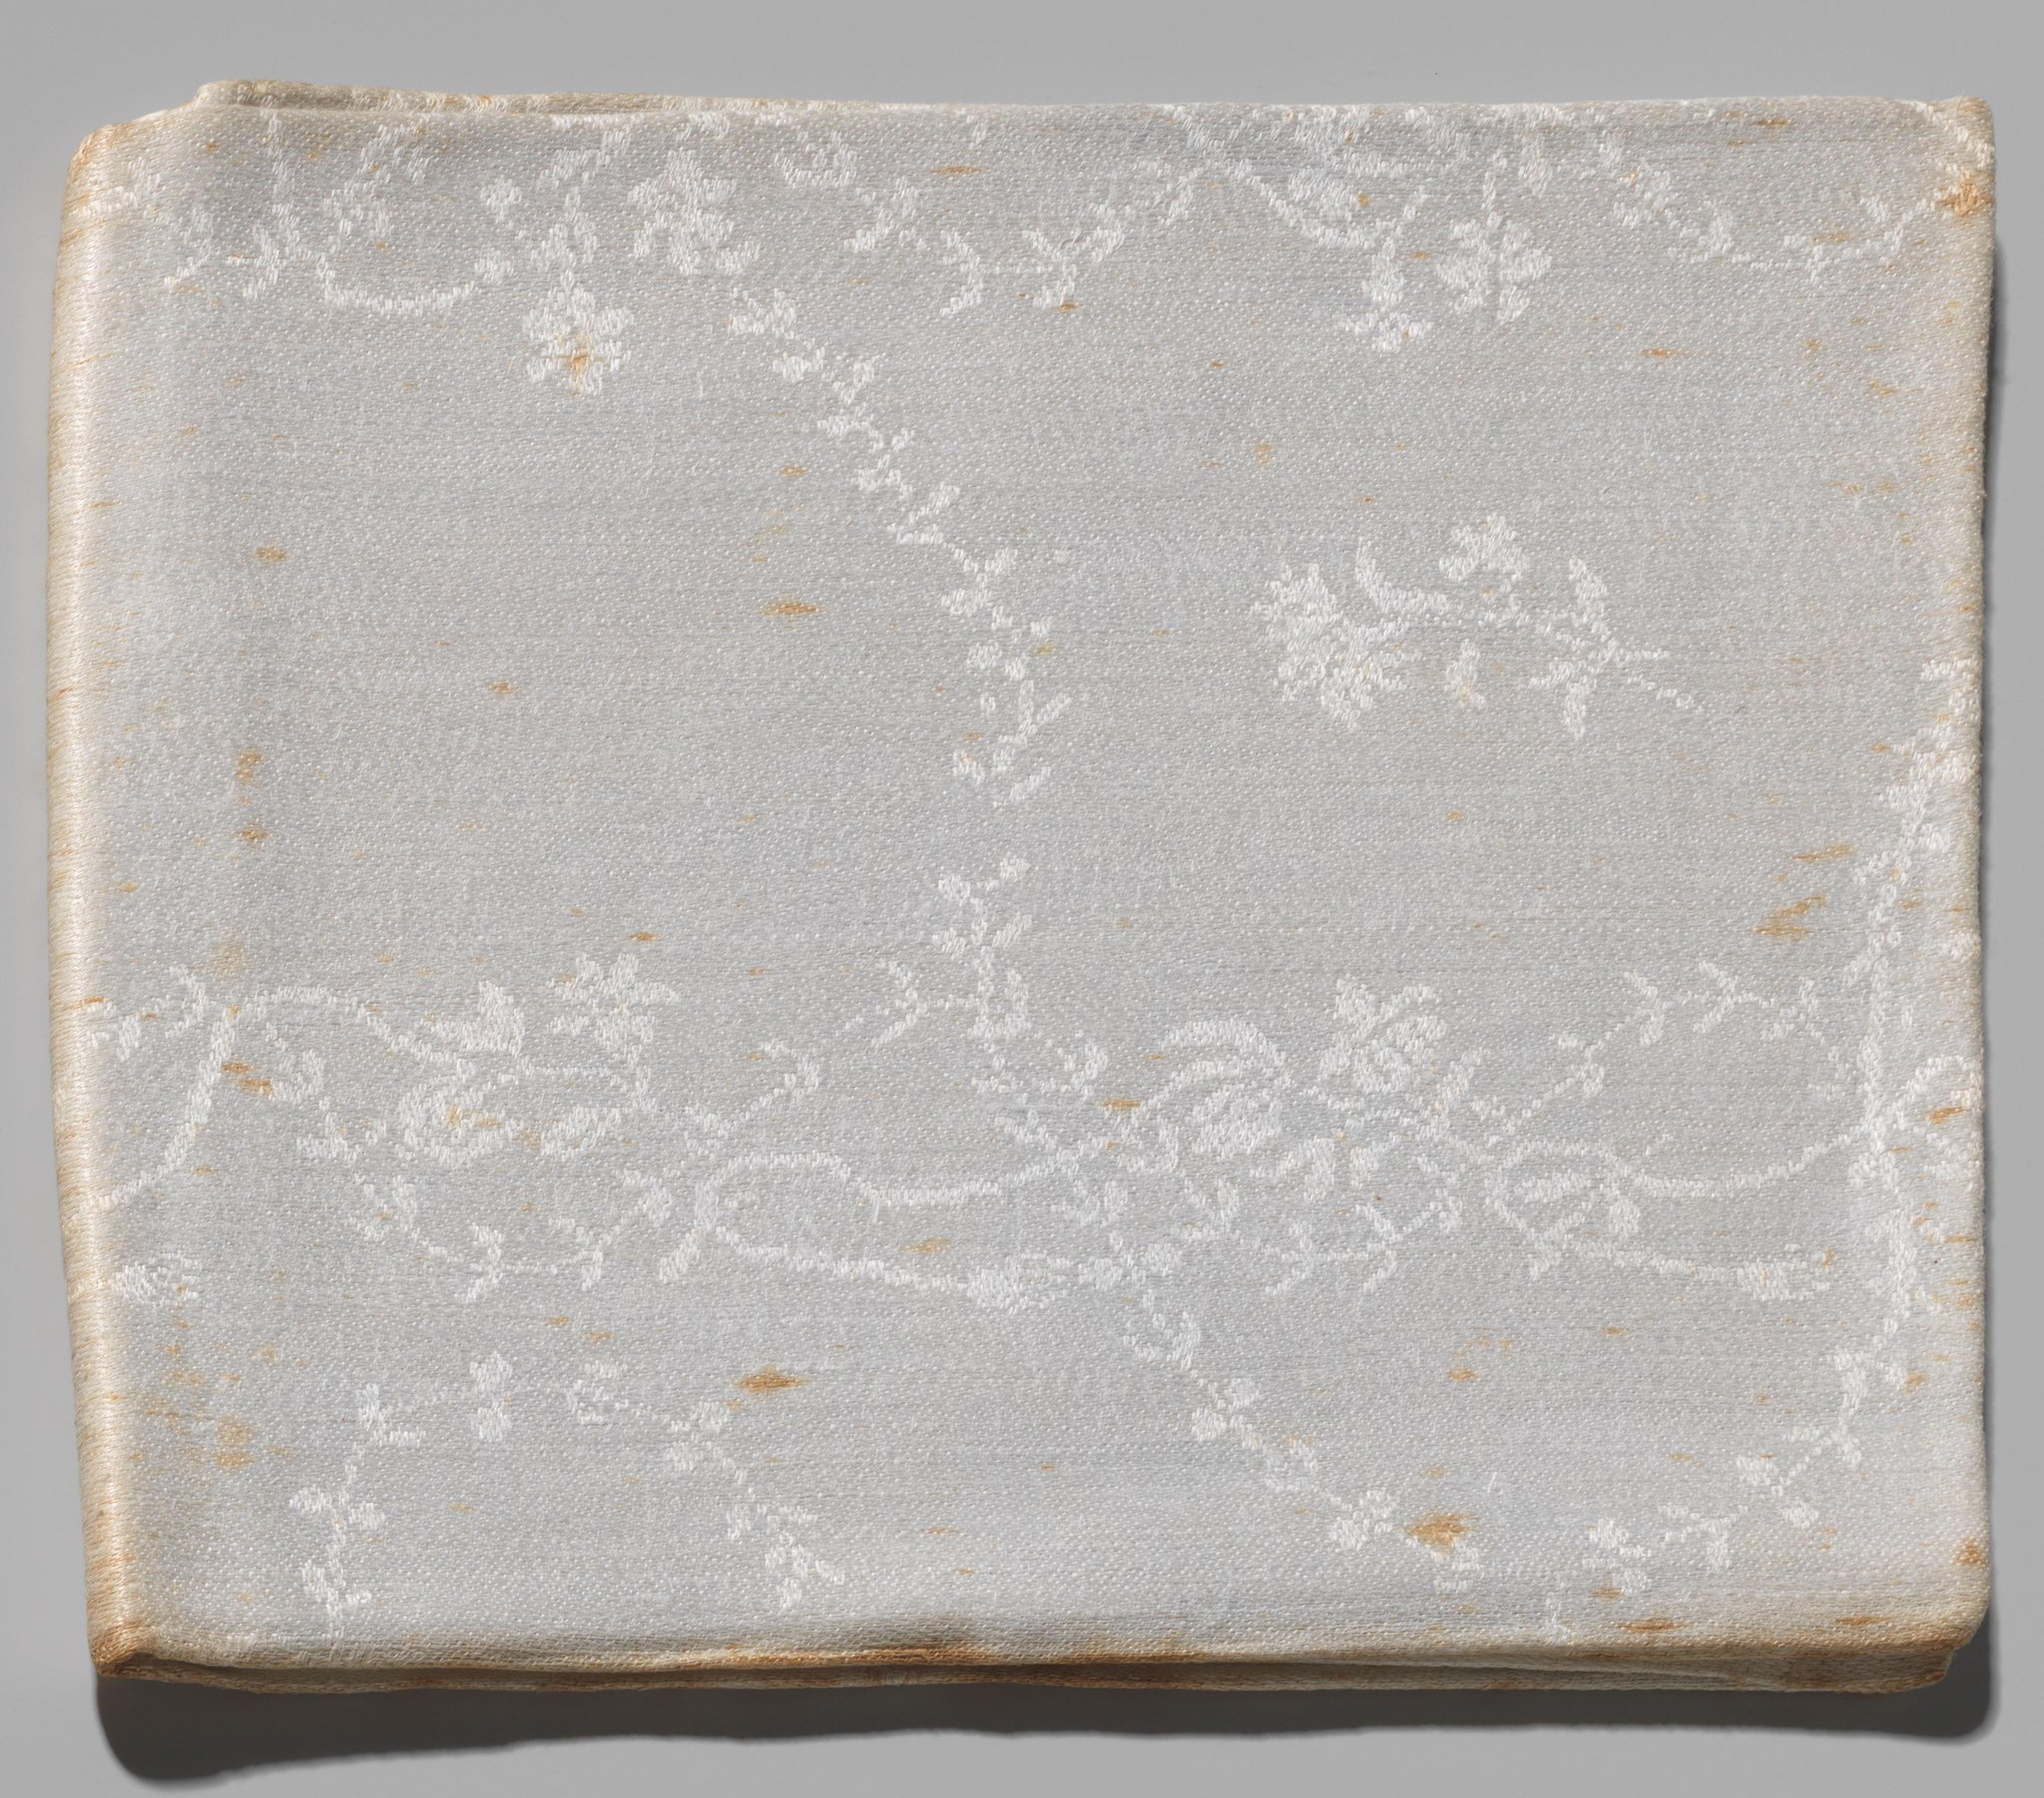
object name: napkin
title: Servet met bloemen en slingers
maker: Anonymous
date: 1800-1810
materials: linen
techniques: damask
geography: brabant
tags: politician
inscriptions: mark: ‘IVDH 24’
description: Servet van linnendamast met bloemen en slingers. Middenveld: een rechtopgaande fijne slingerende tak, met koord en kwast gebonden, wordt door een breed golvende bebladerde tak doorsneden. Randen: driemaal een rechte lijst, spiraalsgewijs omwonden; de middelste is breed en met bladeren omwonden, de buitenste smal en met een fijne bloementak omrankt.